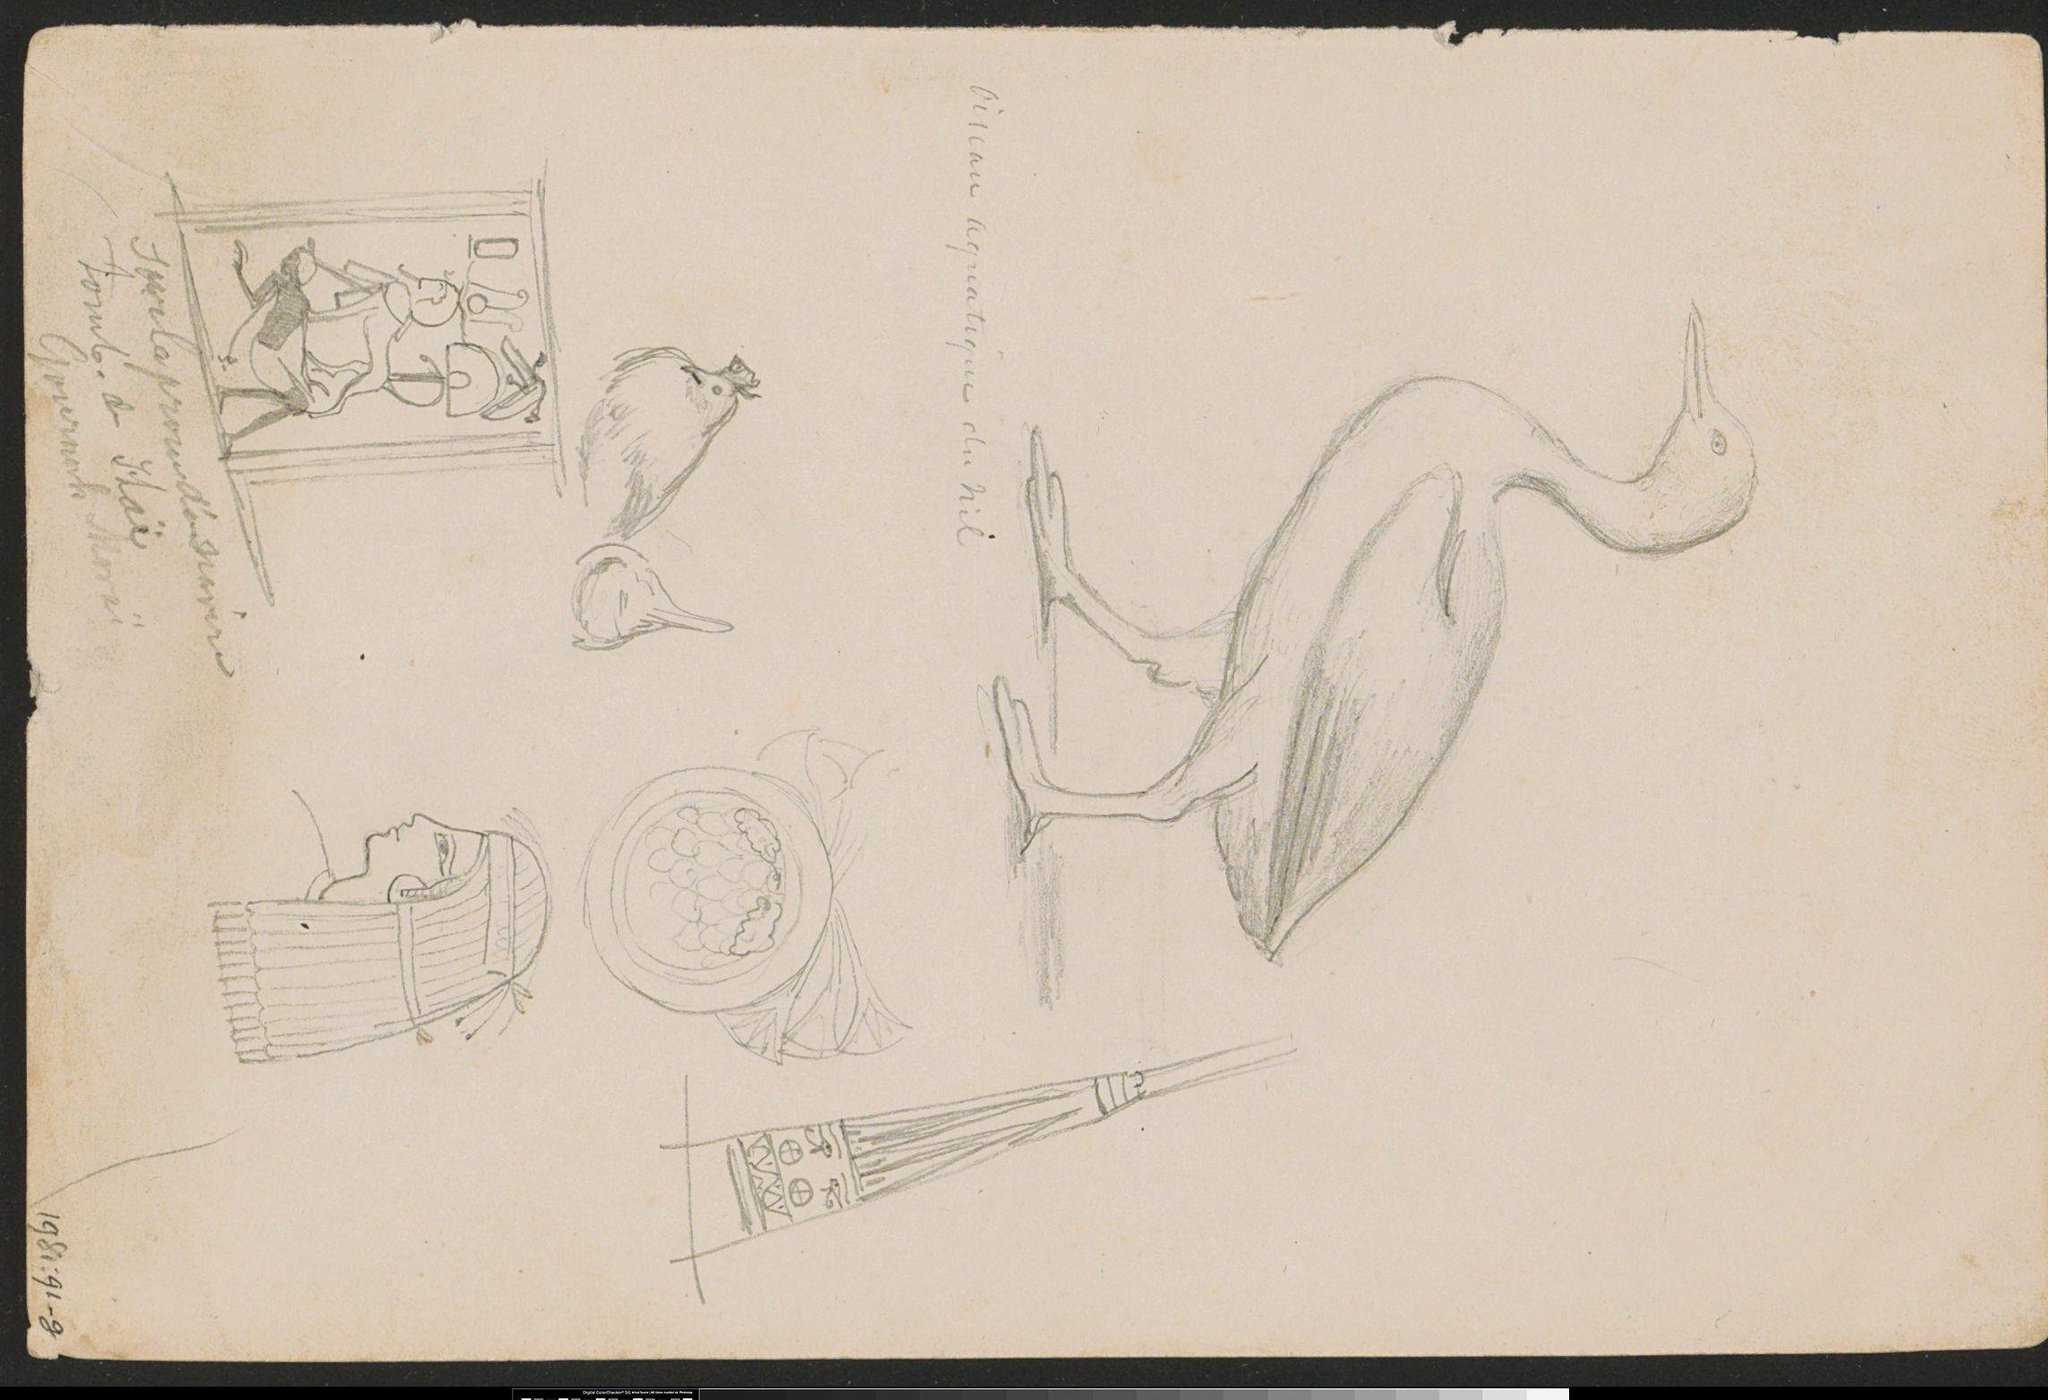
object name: sketchbook leaf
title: Studieblad, onder andere met een watervogel en grafschildering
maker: willem de famars testas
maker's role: draughtsman, painter, print maker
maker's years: 1834-1896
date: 1858-1860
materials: paper, pencil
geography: egypt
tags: water-birds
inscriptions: annotation: ‘oiseau aquatique du Nil/ sur la proud[...]d'[...] navere/ tombe du I[...]aï/ Gour[...] Moraï’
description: Tevens studies van vogels en een kop met Egyptische haardracht. Recto-zijde van een los blad behorende bij een schetsboek met 23 bladen met schetsen gemaakt tijdens een reis door Egypte.